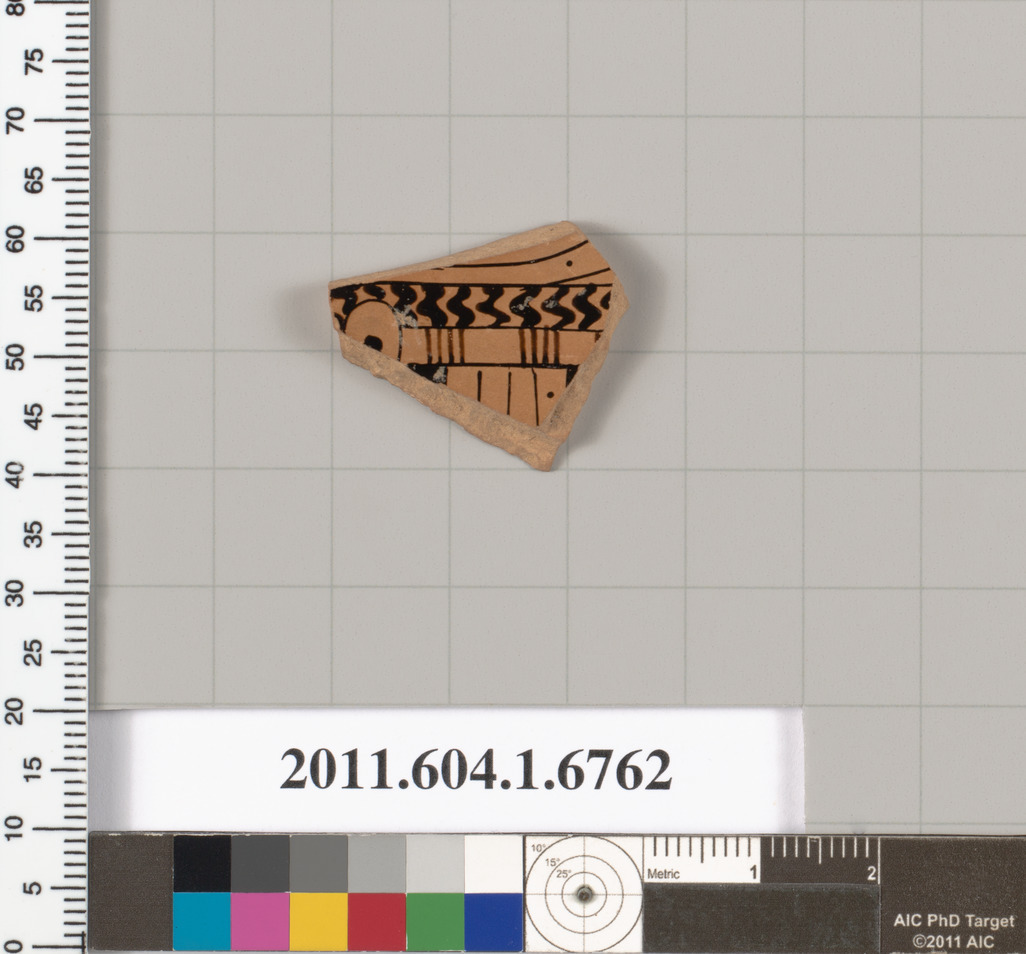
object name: kylix fragment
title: Terracotta fragment of a kylix (drinking cup)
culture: greek, attic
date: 490-470 BCE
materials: terracotta